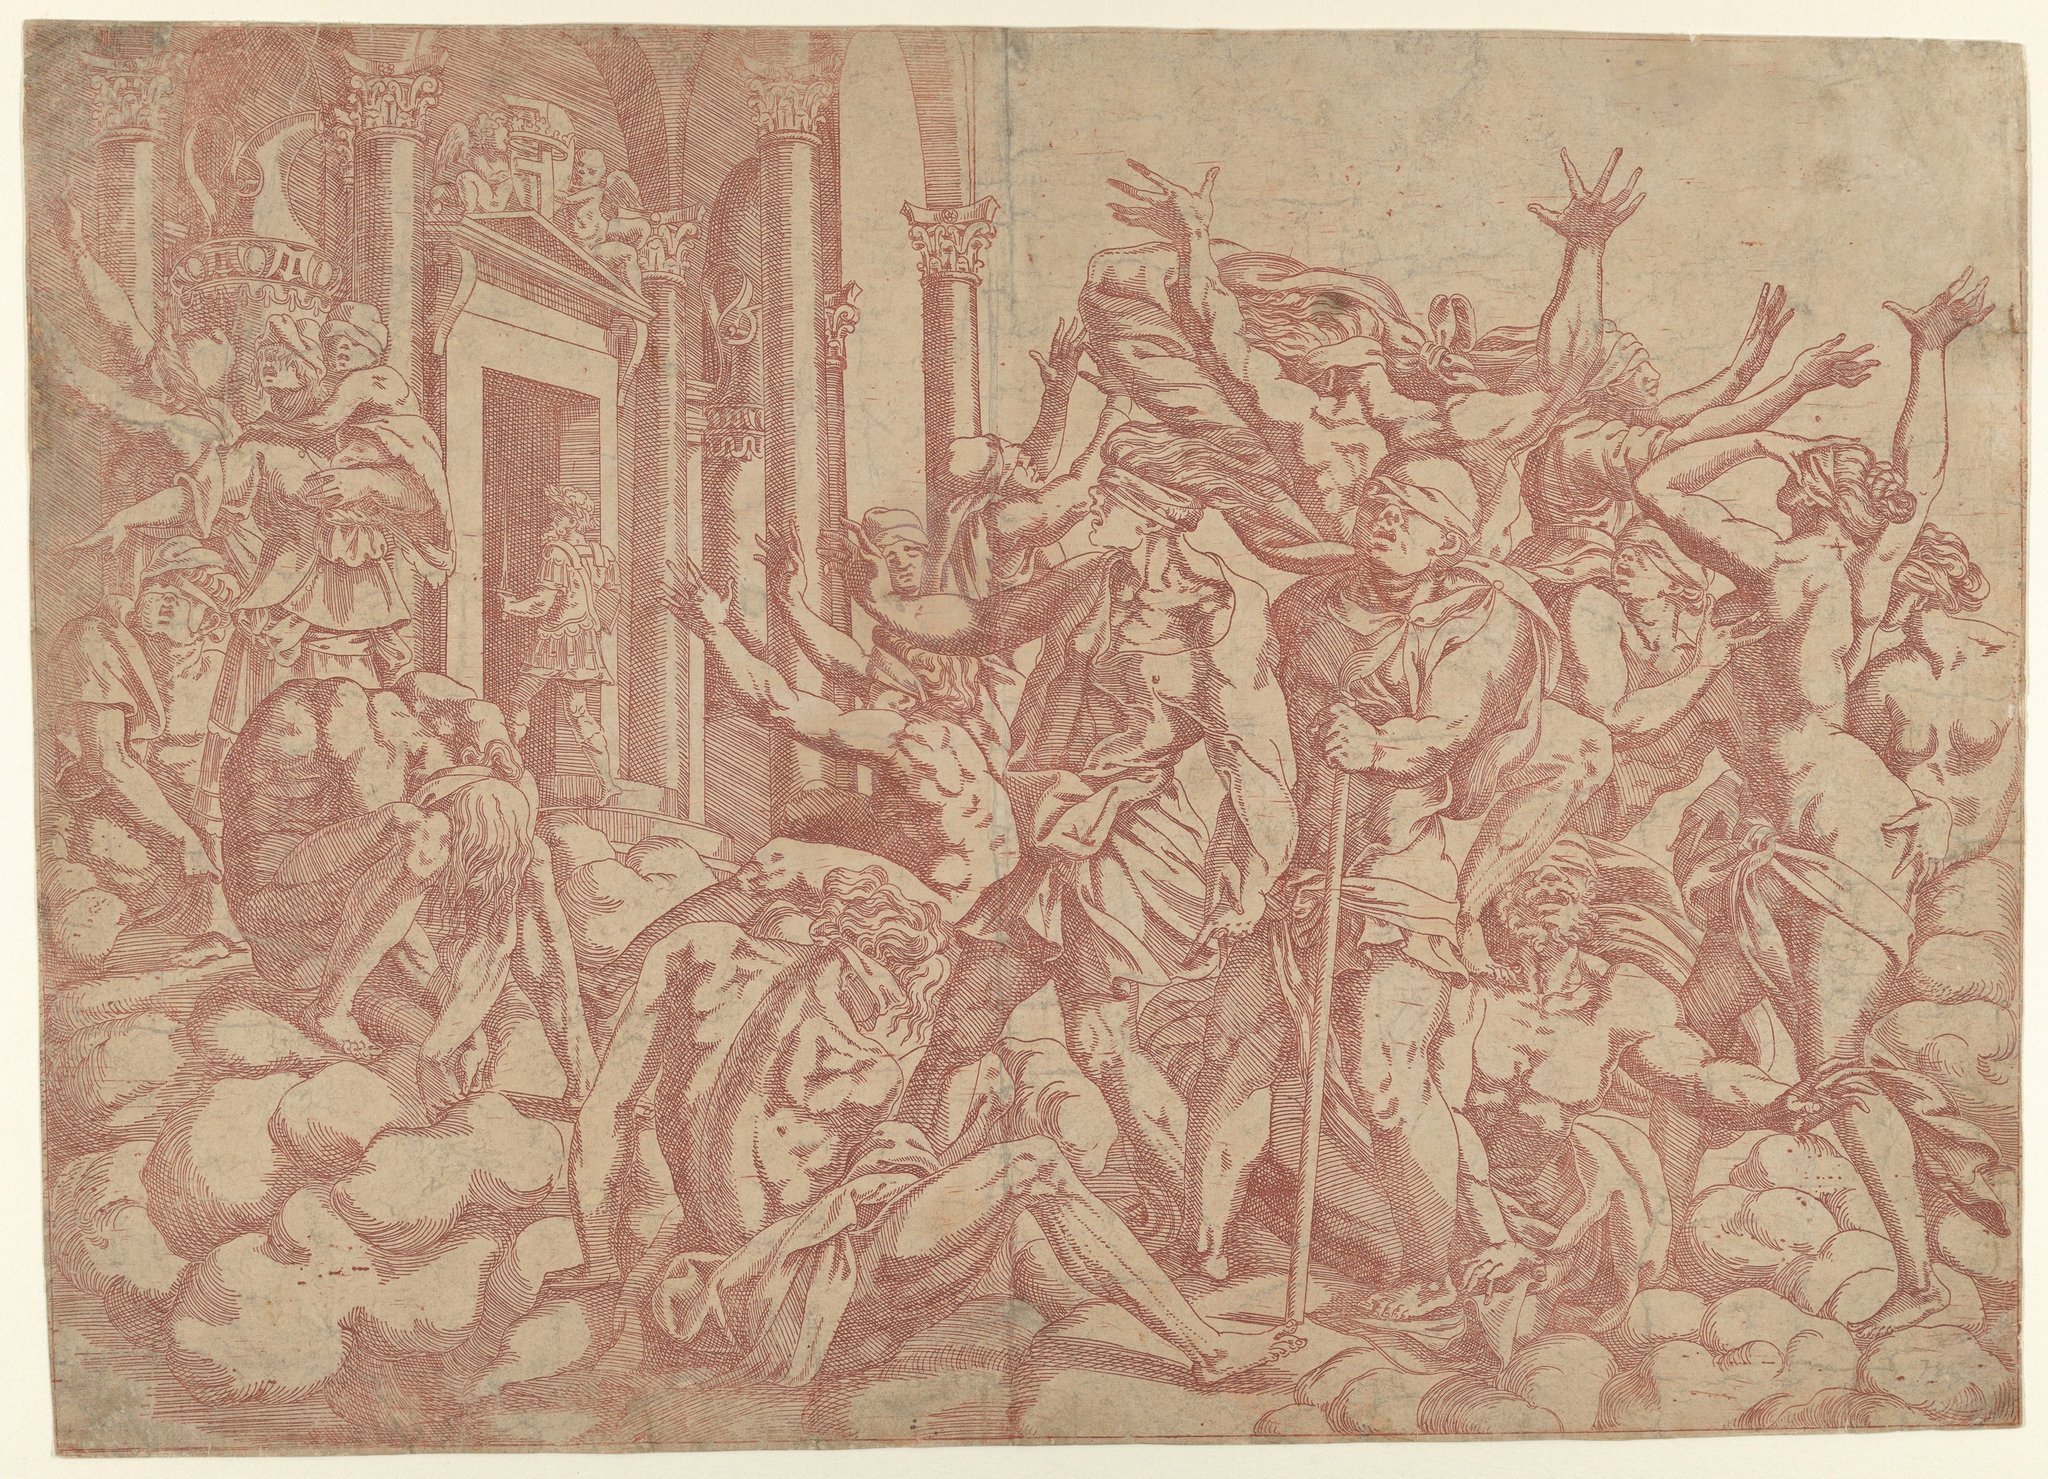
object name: print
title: Ignorance Defeated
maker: antonio fantuzzi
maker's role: artist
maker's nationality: italian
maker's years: 1537-1545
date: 1540-1545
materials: ink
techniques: etching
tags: soldiers,men,female nudes